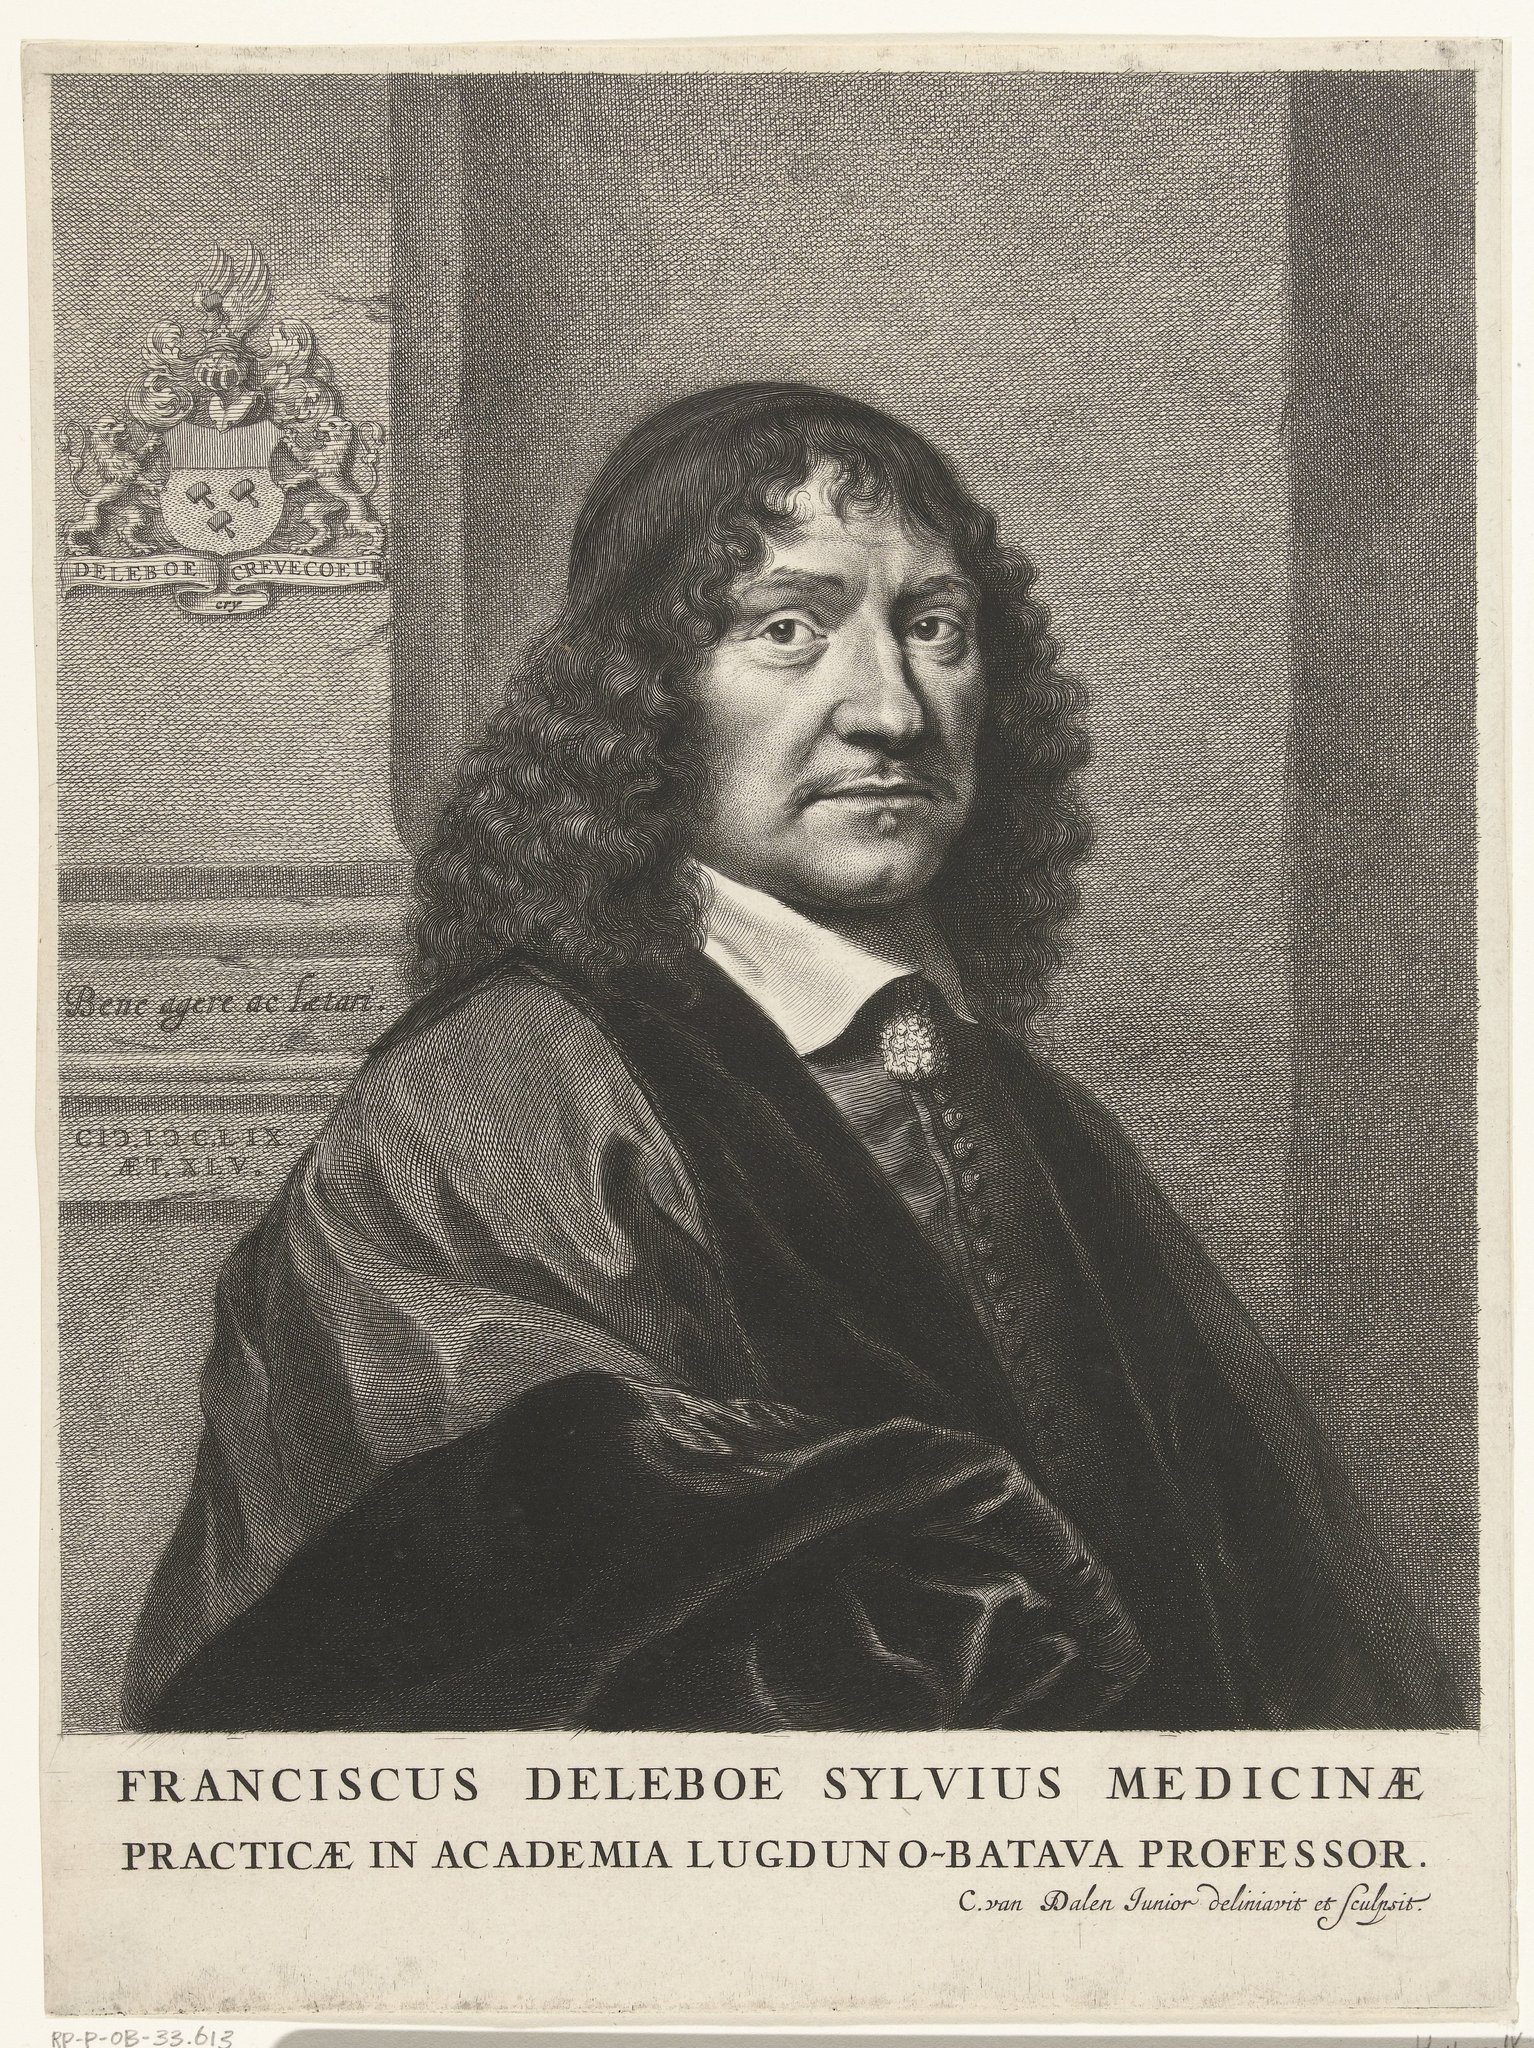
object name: print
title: Franciscus Deleboe Sylvius medicinae practicae in academia Lugduno-Batava professor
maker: cornelis van dalen (ii)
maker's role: draughtsman, print maker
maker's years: 1638-1664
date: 1659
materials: paper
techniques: engraving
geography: amsterdam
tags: leiden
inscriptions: collector's mark: Lugt 240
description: Portret van medicus Franciscus de le Boë Sylvius op 45-jarige leeftijd, borststuk met op achtergrond zijn wapen in reliëf op de muur. Op een richel staat zijn motto Bene agere ac laetari.